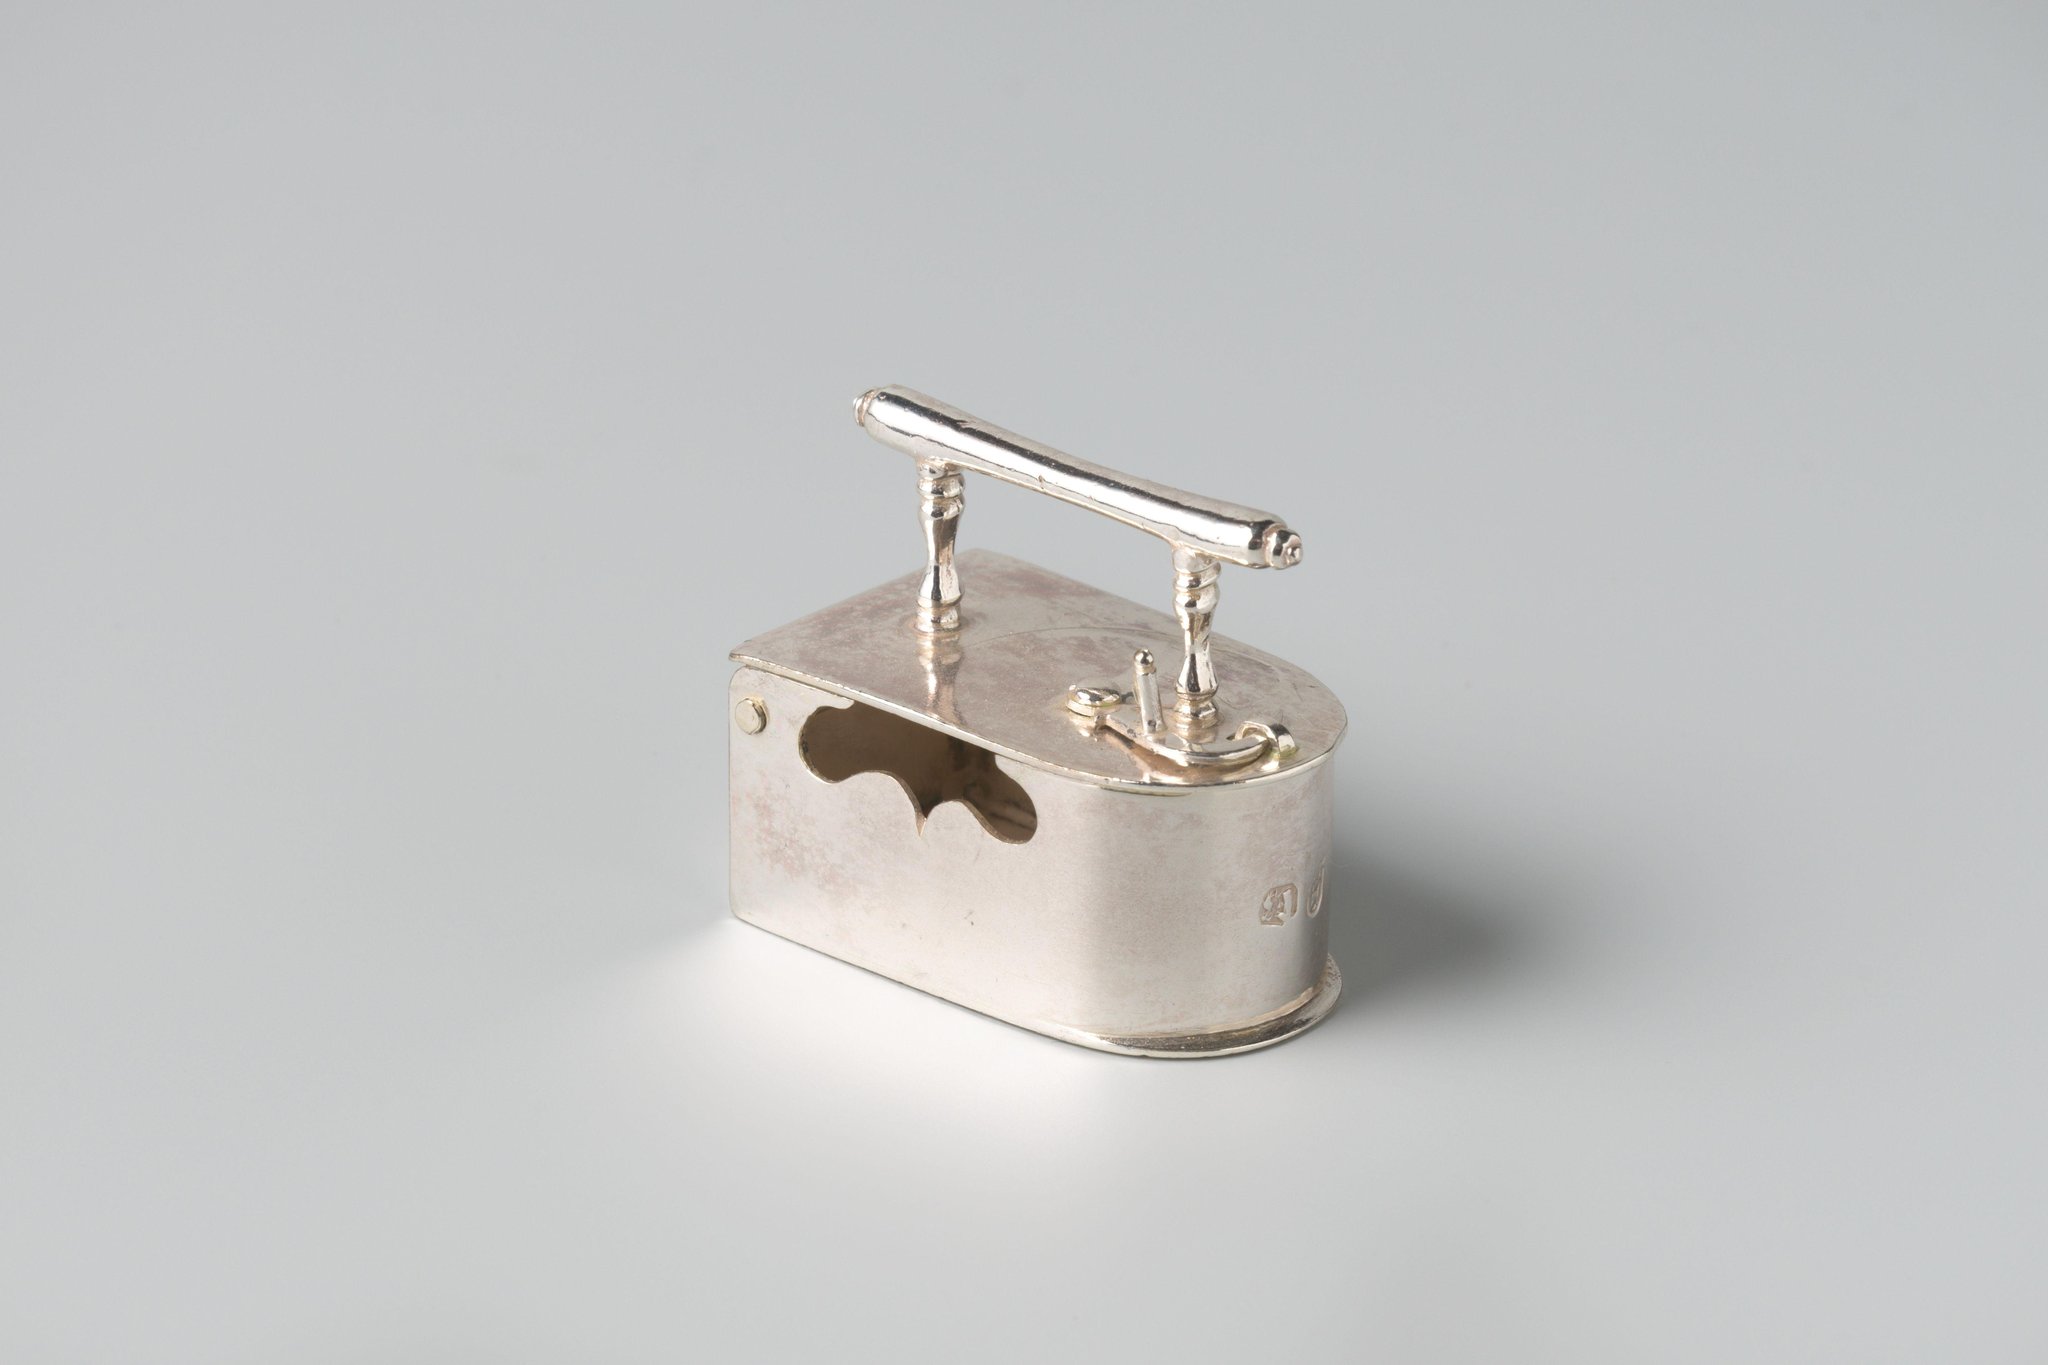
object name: miniature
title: Strijkijzer van zilver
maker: frederik van strant (i)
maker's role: silversmith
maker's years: 1678-1727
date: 1706-1727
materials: silver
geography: amsterdam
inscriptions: town mark: ‘kleine stadskeur Amsterdam’, maker's mark: ‘FS (Citroen 1975, nr. 231)’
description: Strijkijzer van zilver met schrnierend en door een haak af te sluiten deksel met handvat, de wanden van de kooltjesbak met uitgezaagde accoladeversiering. Hierbij hoort een rooster (B).